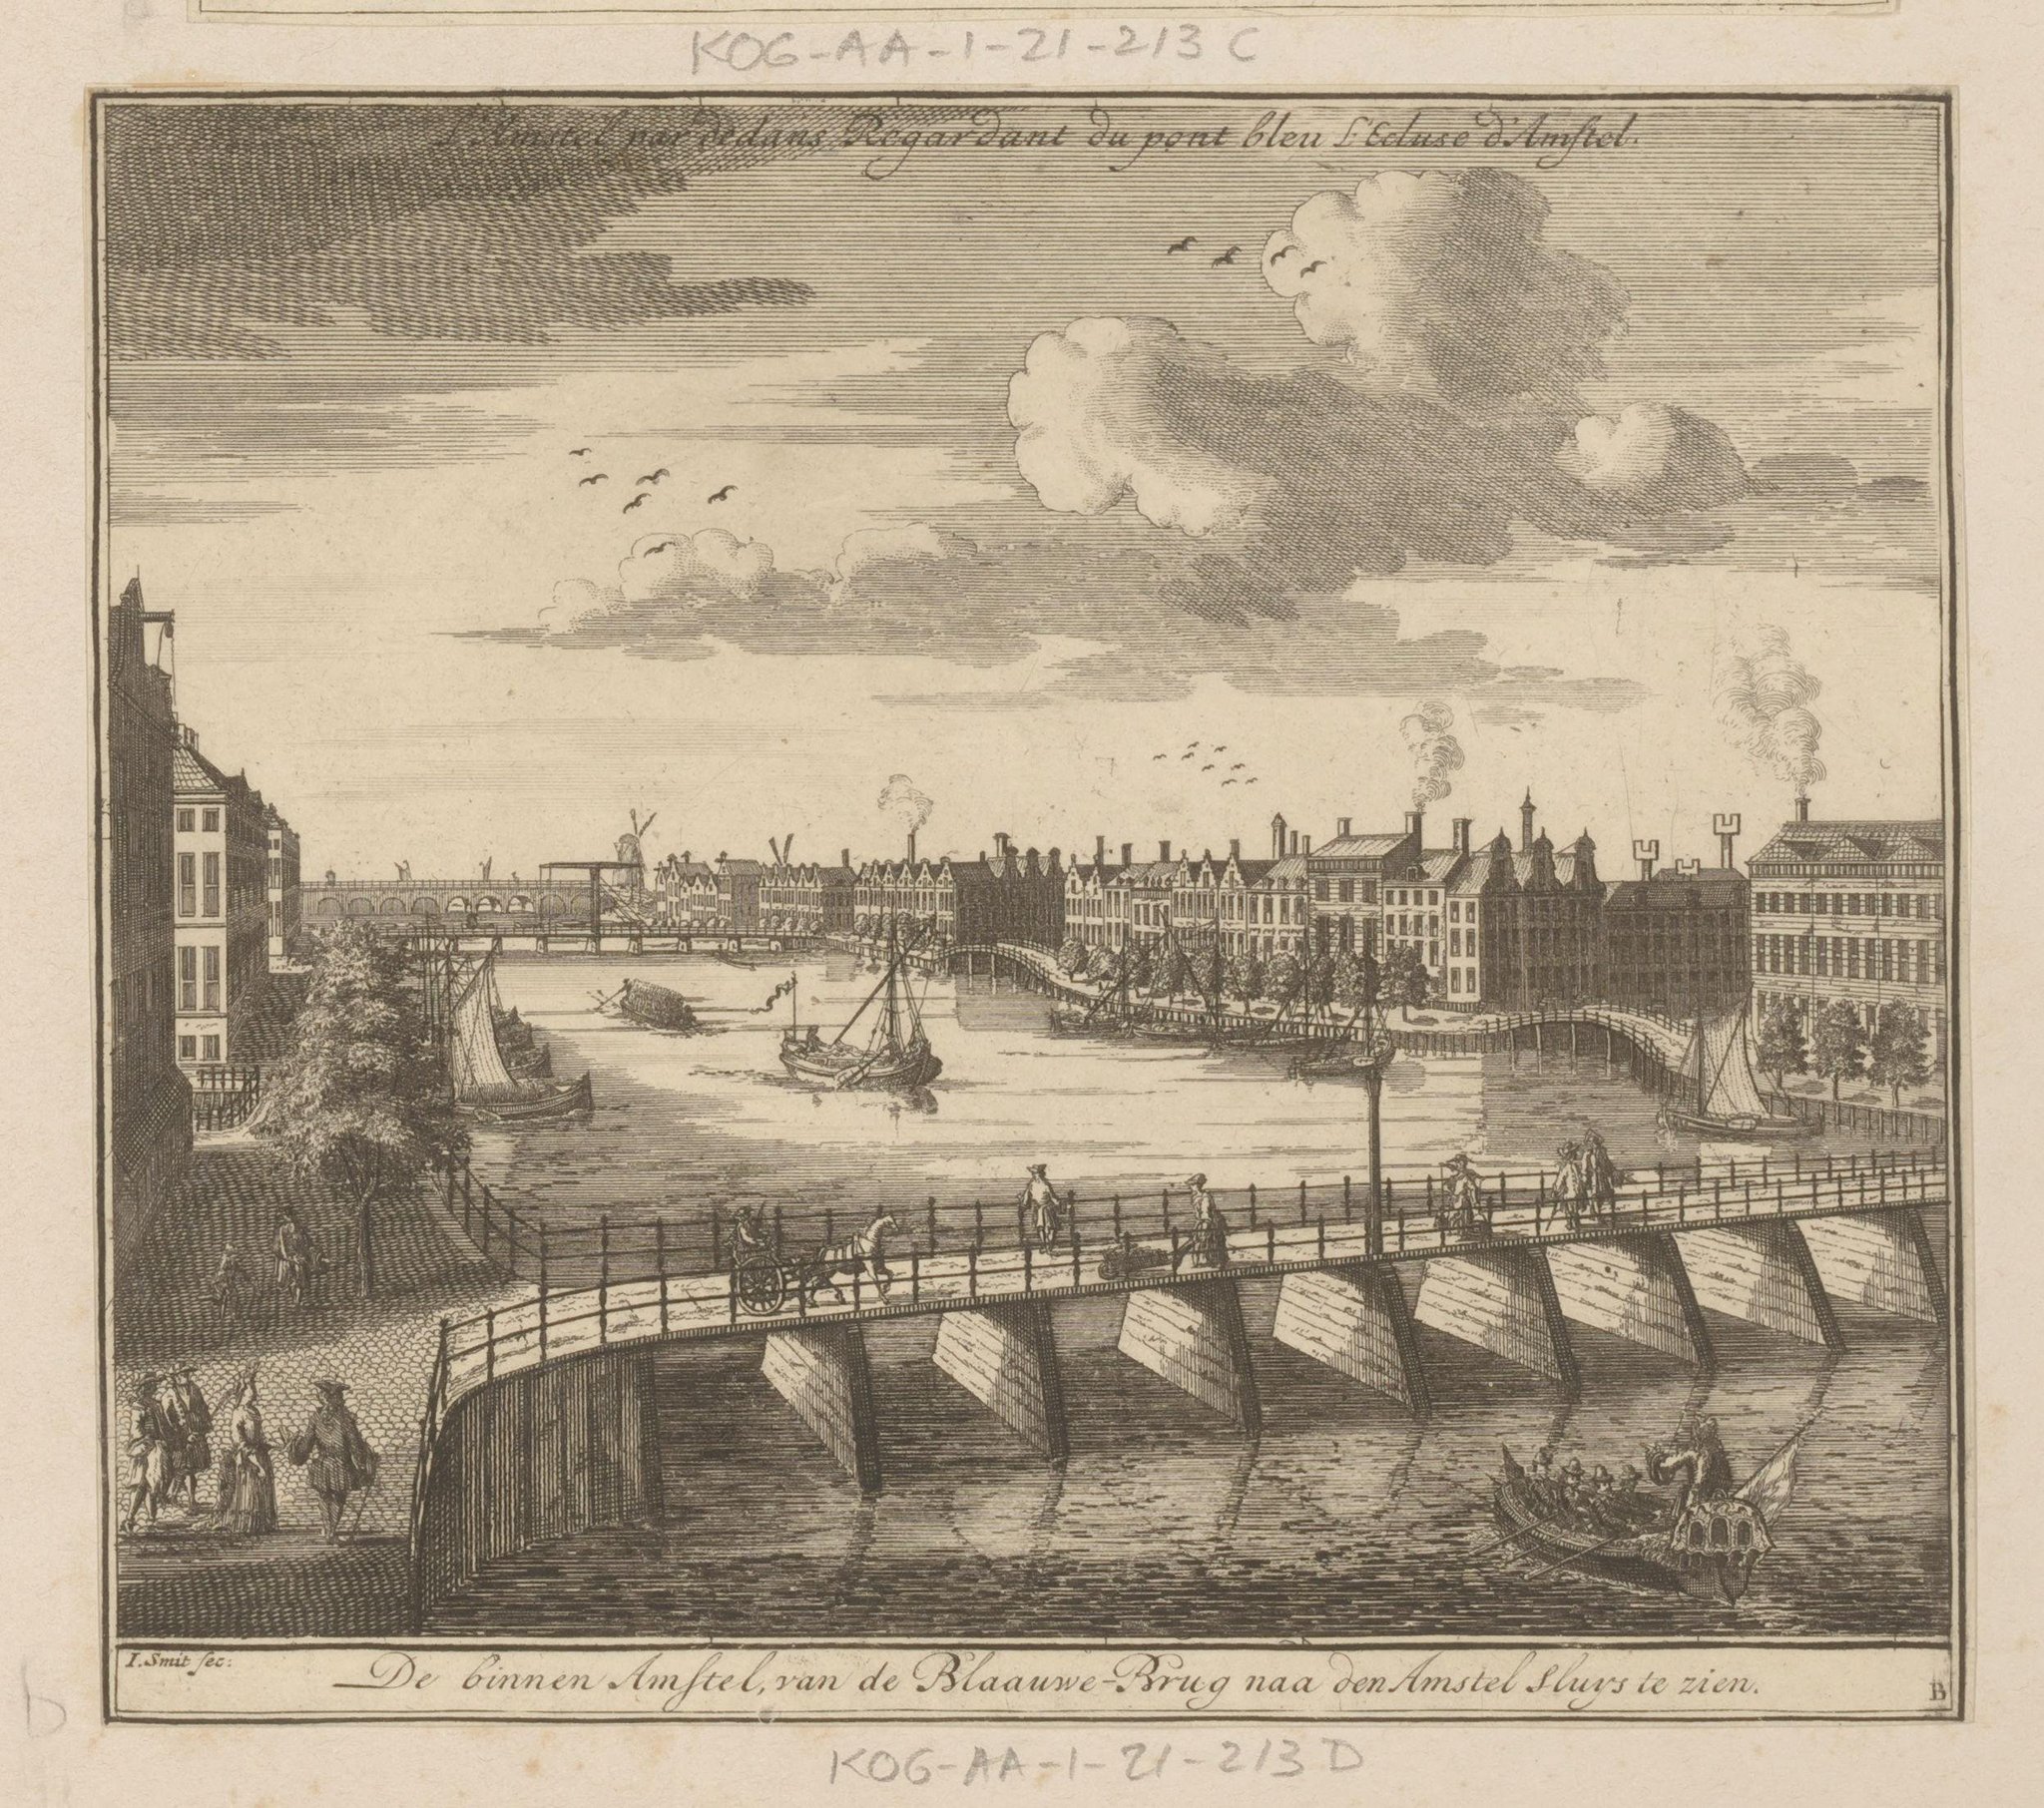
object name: print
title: L'Amstel par dedans Regardant du pont bleu l'Ecluse d'Amstel / De binnen Amstel, van de Blaauwe-Brug naa den Amstel sluys te zien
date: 1700-1748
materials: paper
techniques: etching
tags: city-view, and landscape with man-made constructions, canals, waters (in city), bridge in city across river, canal, etc., boat propelled by man or animal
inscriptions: collector's mark: Lugt 1641b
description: Rechtsonder: B. Onderwerpsrubriek binnen de Atlas Amsterdam: Bestrating, bruggen, wegen.